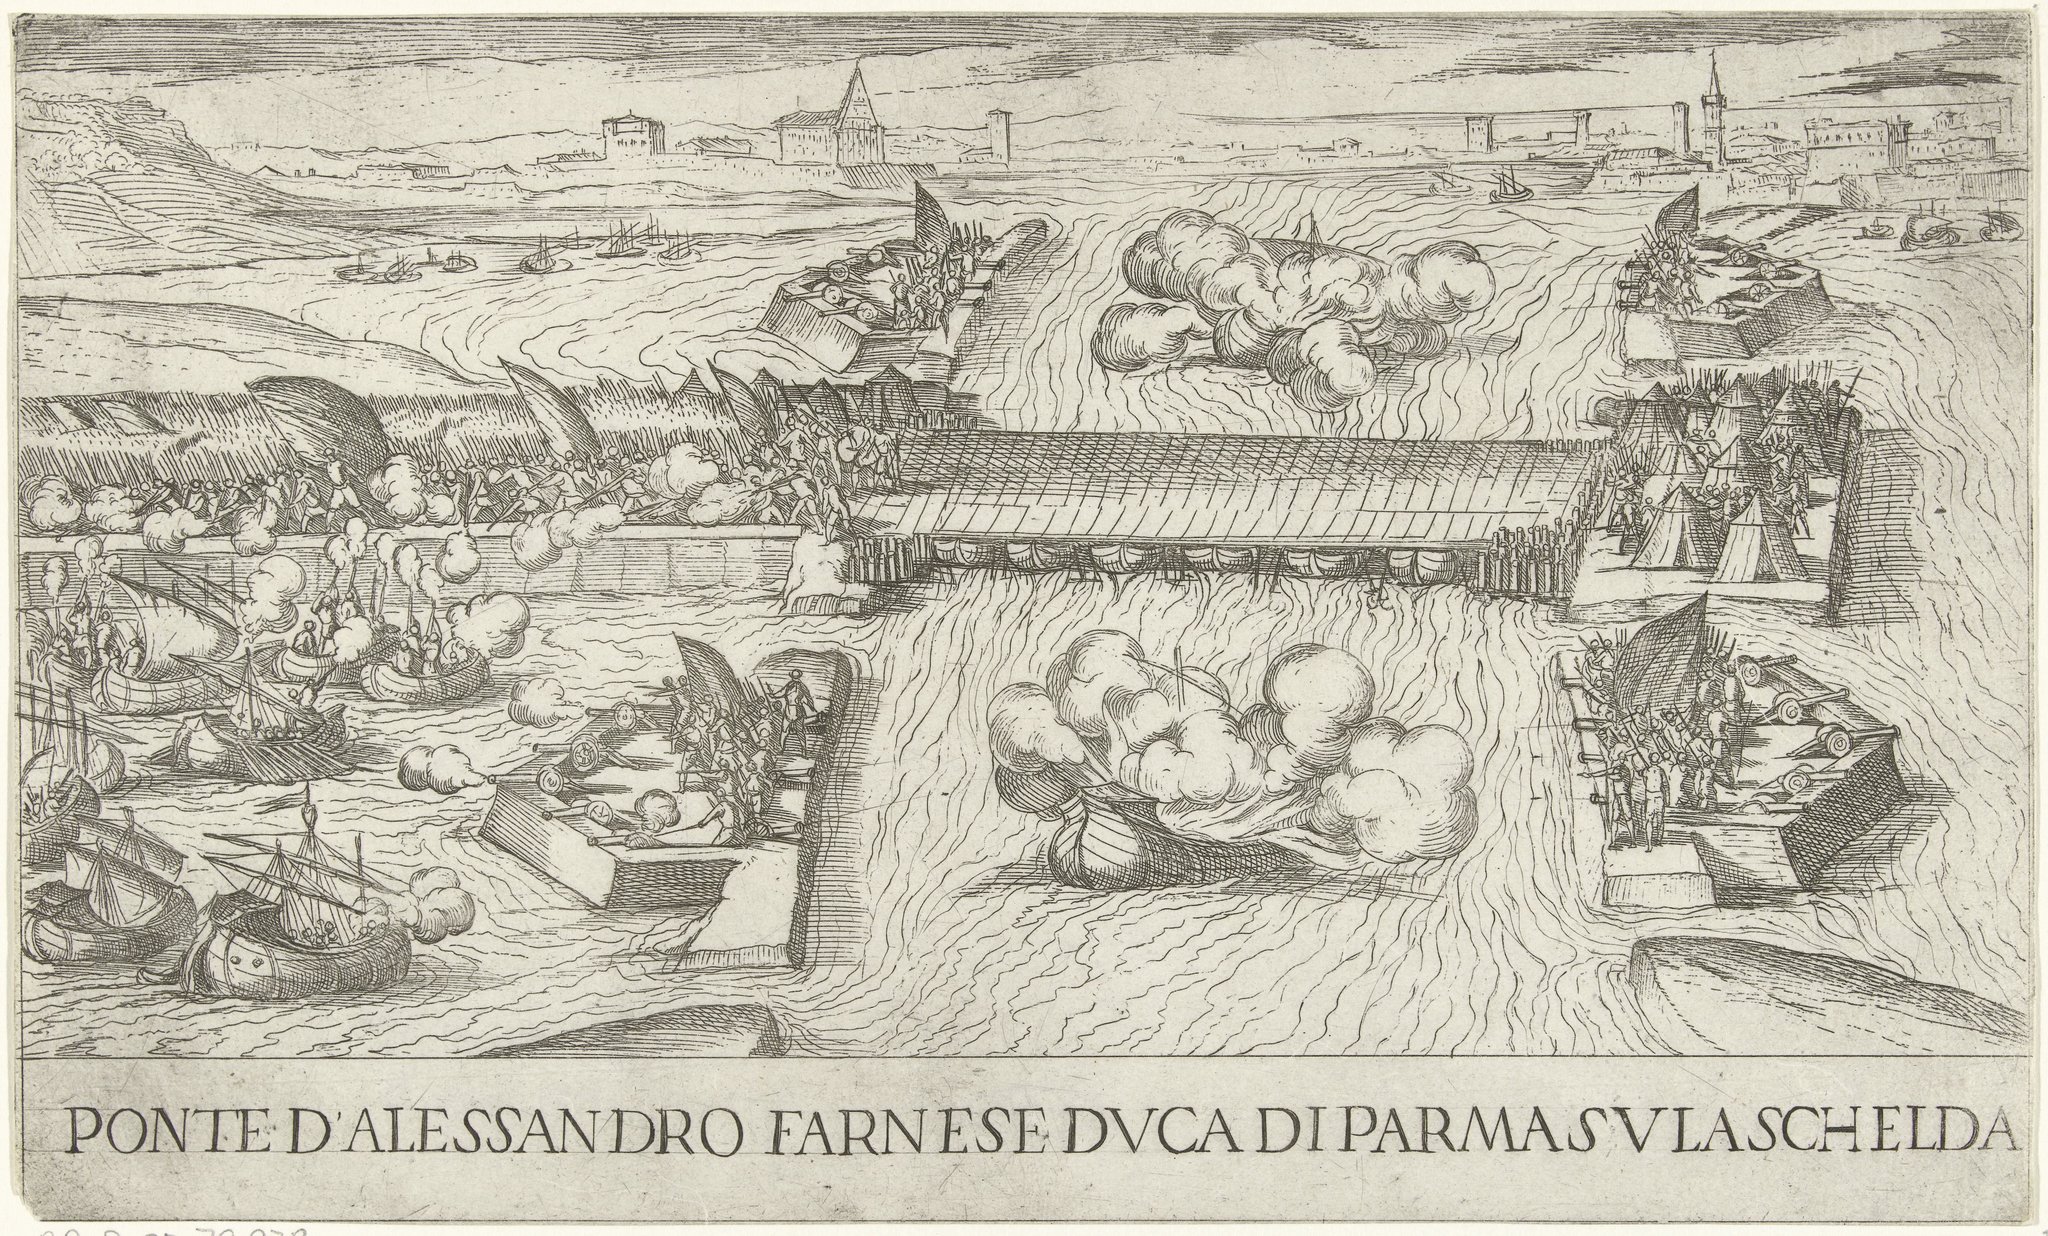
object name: history print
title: Ponte d'Alessandro Farnese duca di Parma sula Schelda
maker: antonio tempesta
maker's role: draughtsman, painter, print maker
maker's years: 1555-1630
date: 1593-1595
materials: paper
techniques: etching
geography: italy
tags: engineer, rome, alessandro farnese (landvoogd van de nederlanden en hertog van parma en piacenza), battle, pontoon bridge, antwerp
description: Gebruikt als illustratie in: F. Patrizi, Paralleli militari, ne'quali si fa paragone delle Milizie antiche, in tutti le parti loro, con le moderne, 2 delen, L. Zannetti, Rome 1594-1595, dl. II, p. 371-373.